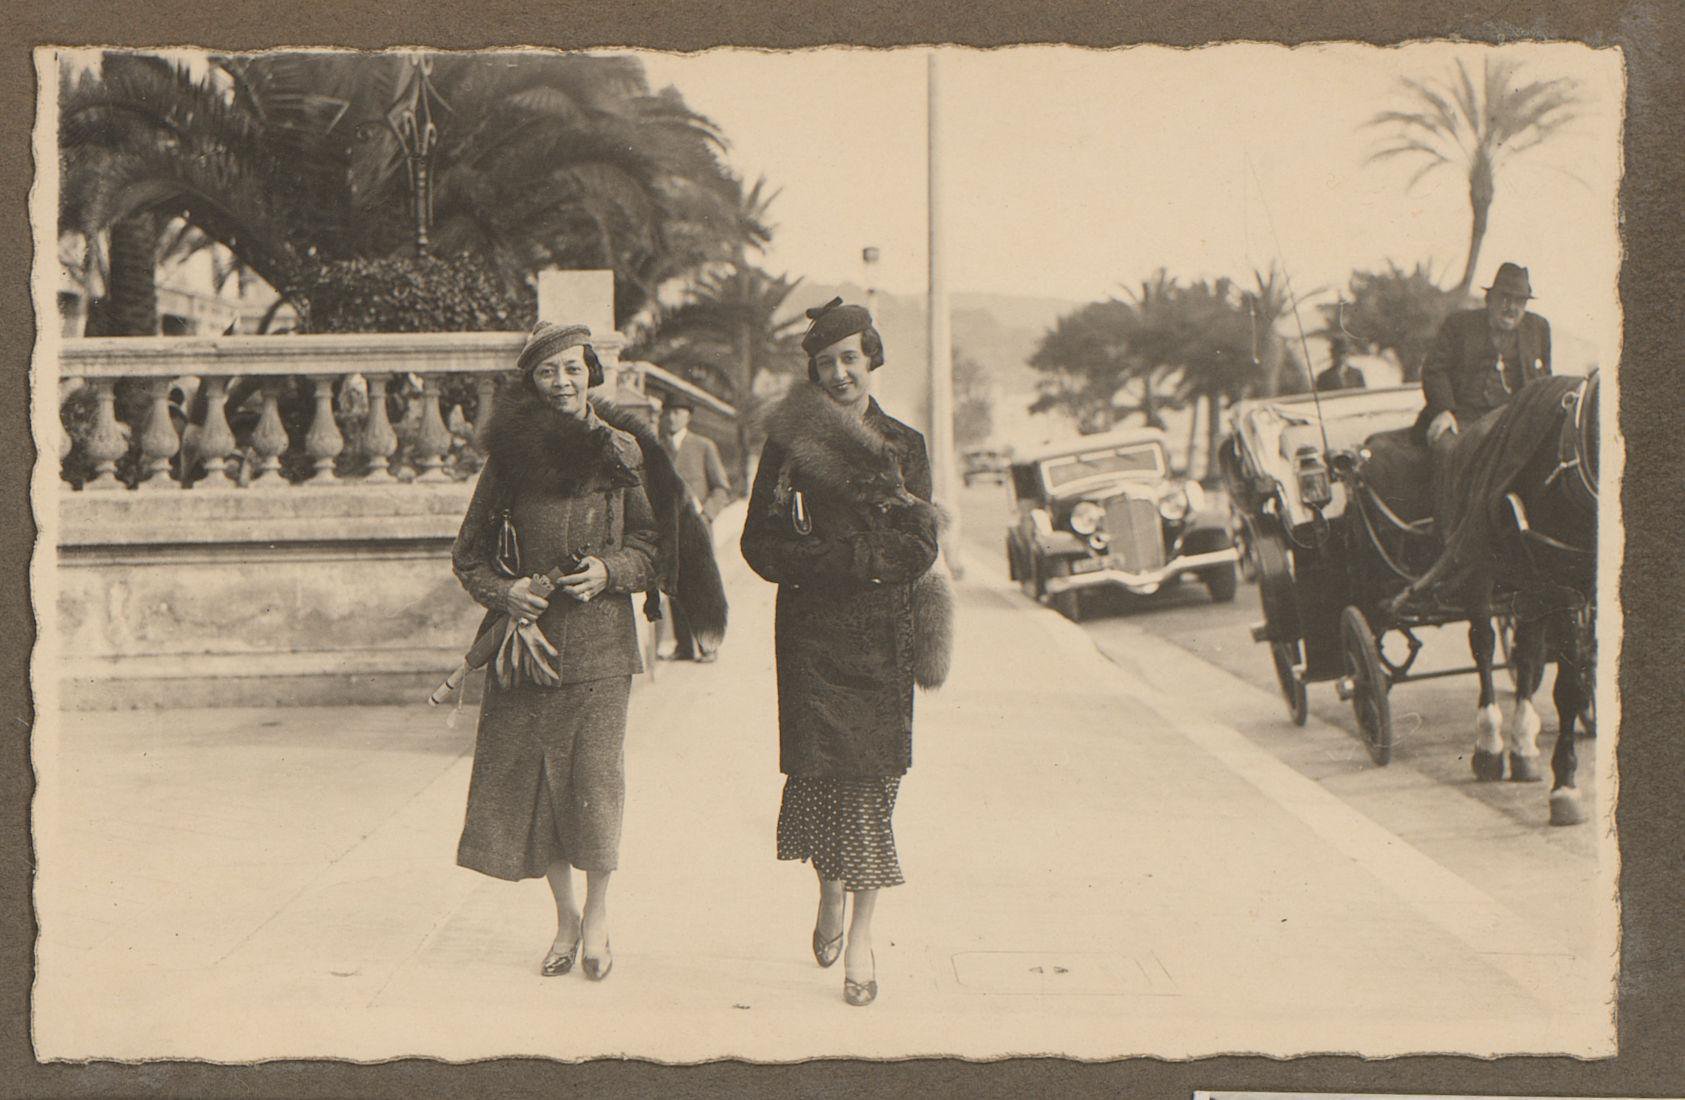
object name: album leaf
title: Portret van Dootje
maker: Anonymous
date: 1934-1935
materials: paper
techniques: gelatin silver print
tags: historical persons - bb - woman